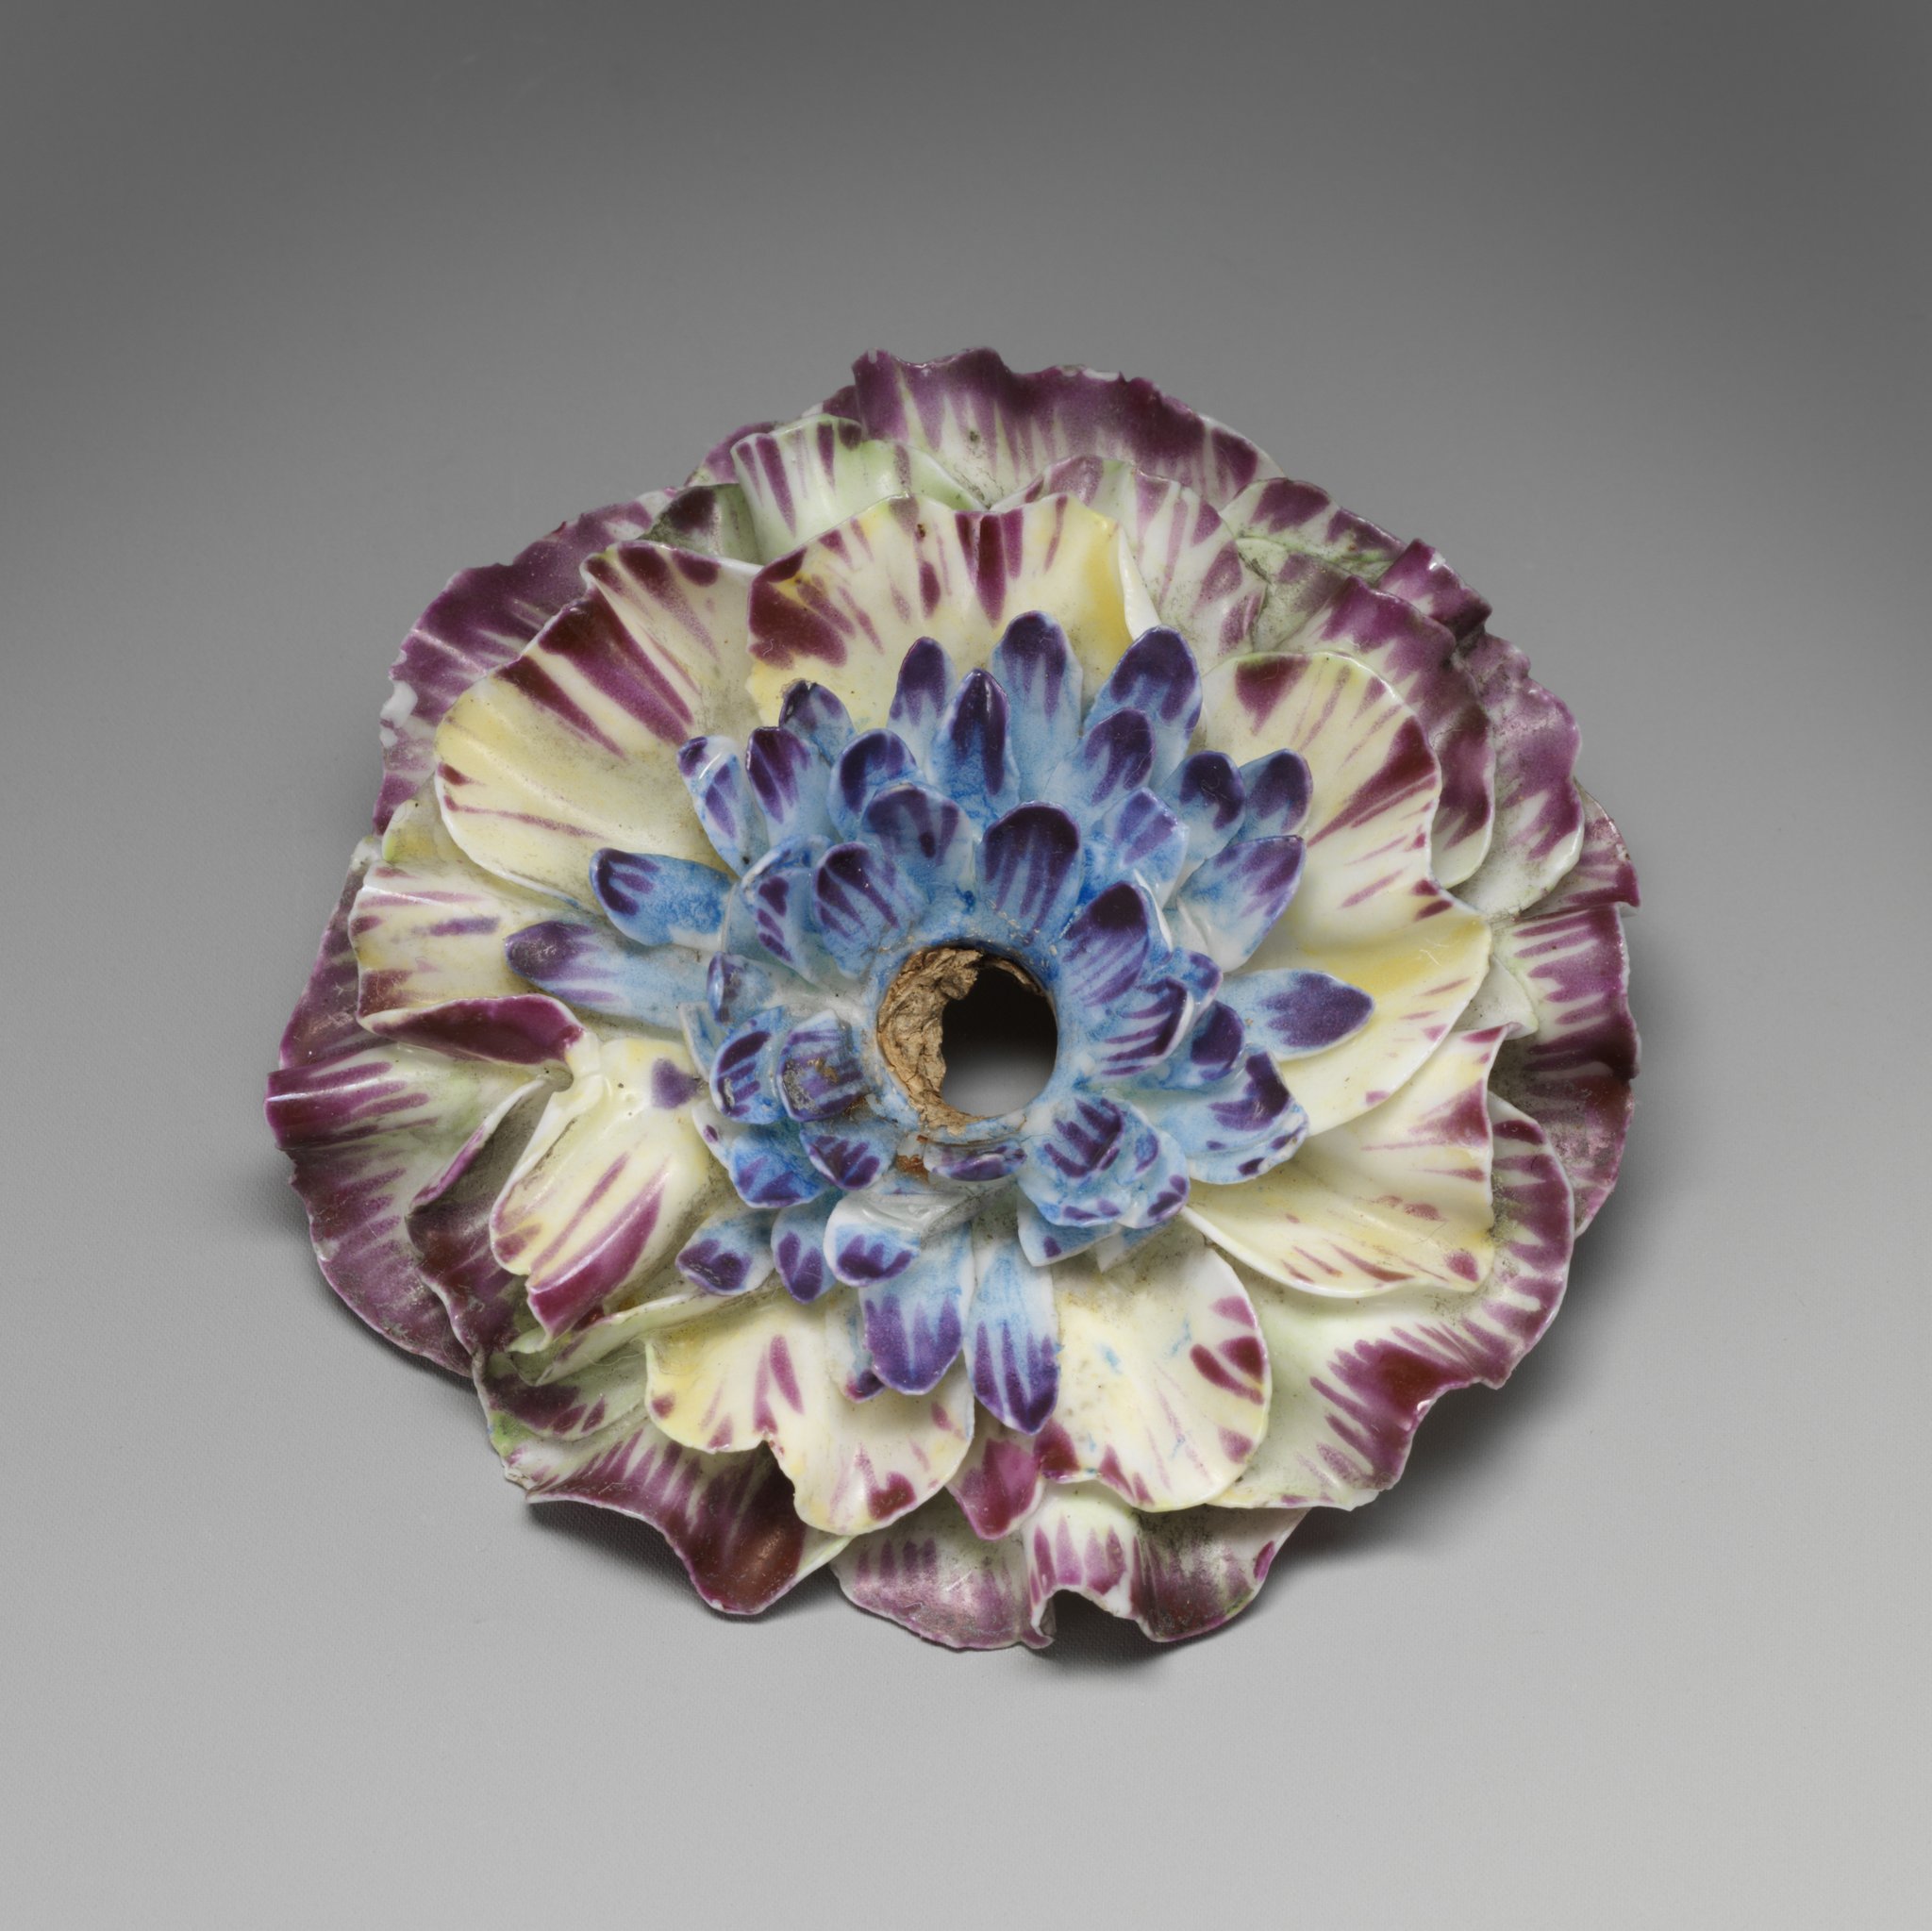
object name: porcelain flower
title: Porcelain flower (one of a set of nine)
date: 1734-1766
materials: soft paste porcelain